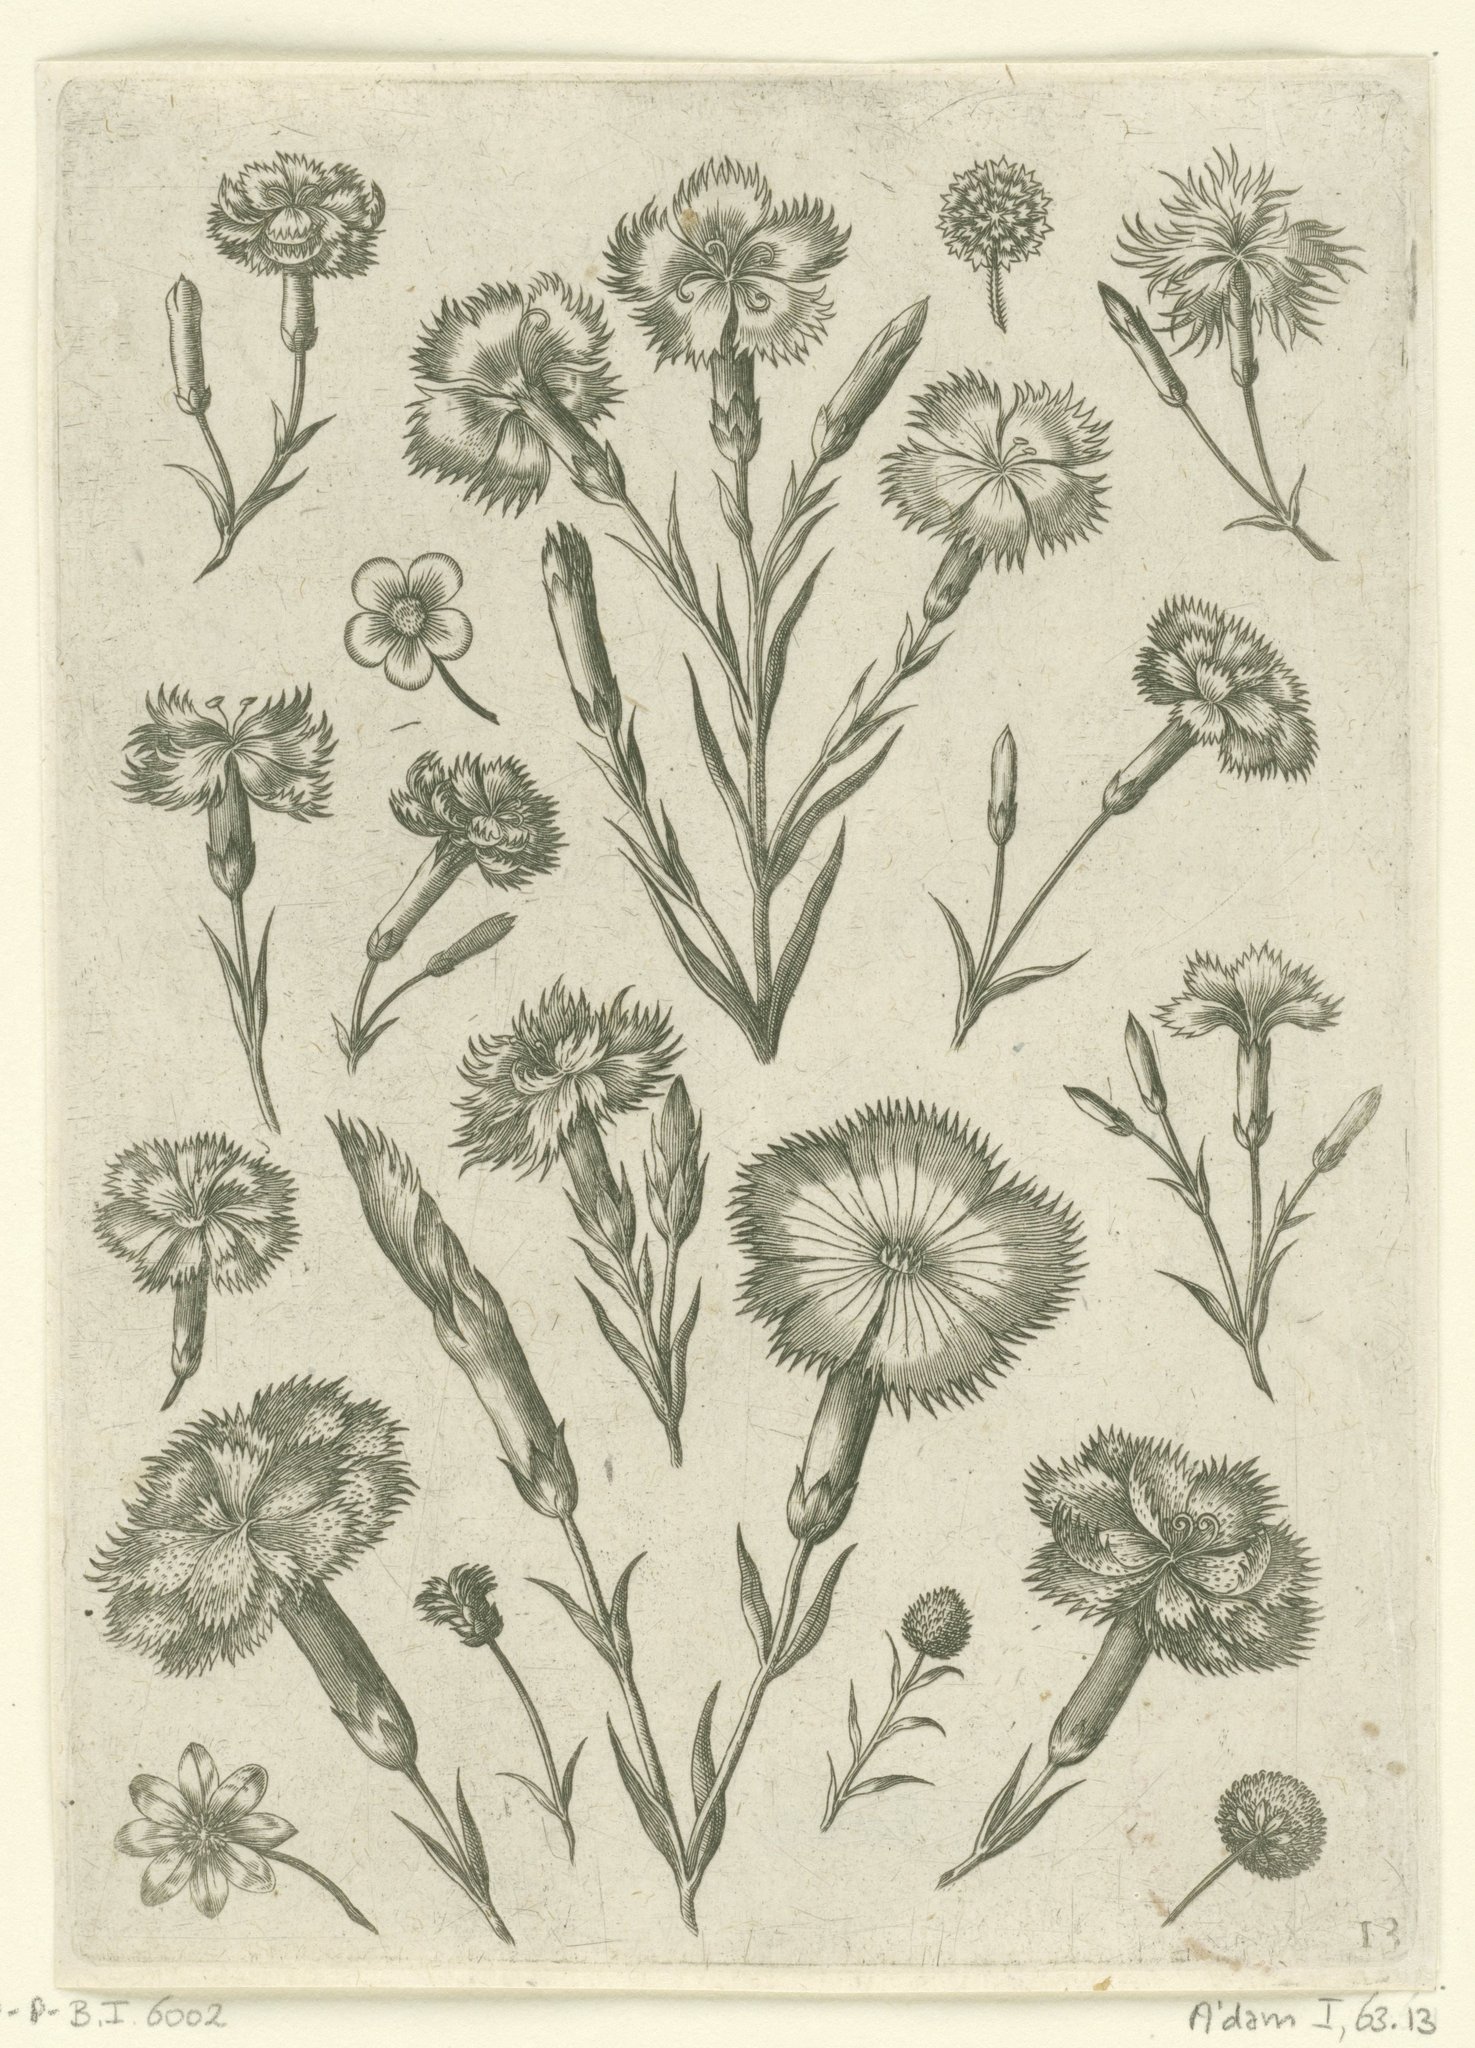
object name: ornament print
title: Florilegium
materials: paper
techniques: engraving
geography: netherlands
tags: flowers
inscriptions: collector's mark: Lugt 240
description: Blad 13 van 21 genummerde bladen met titelblad afkomstig uit een serie van 24.